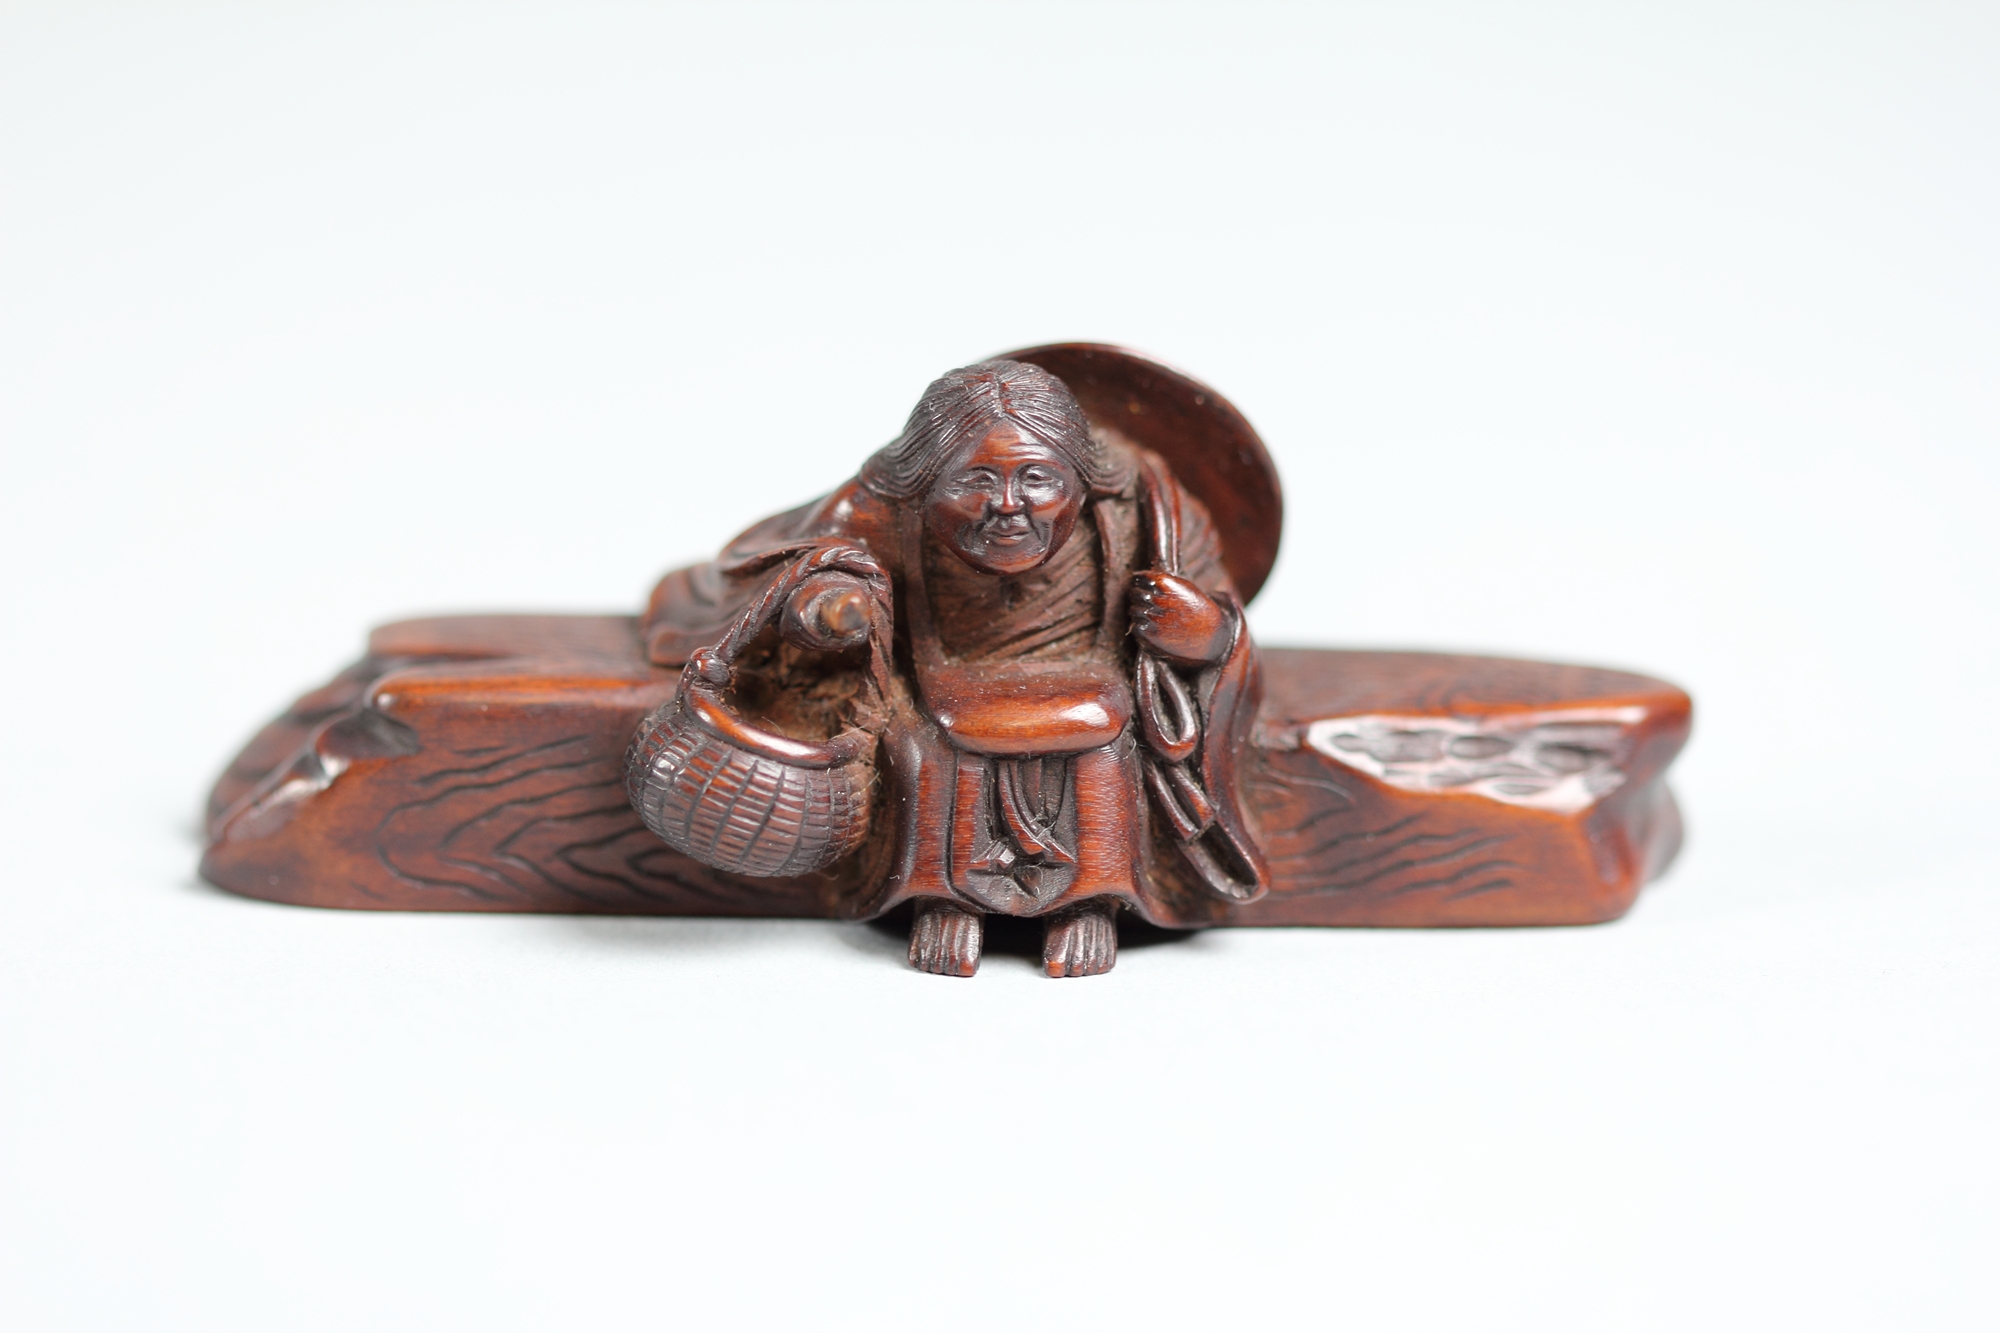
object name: netsuke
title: Netsuke of Woman Sitting on a Log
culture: japanese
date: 1801-1900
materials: wood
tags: women